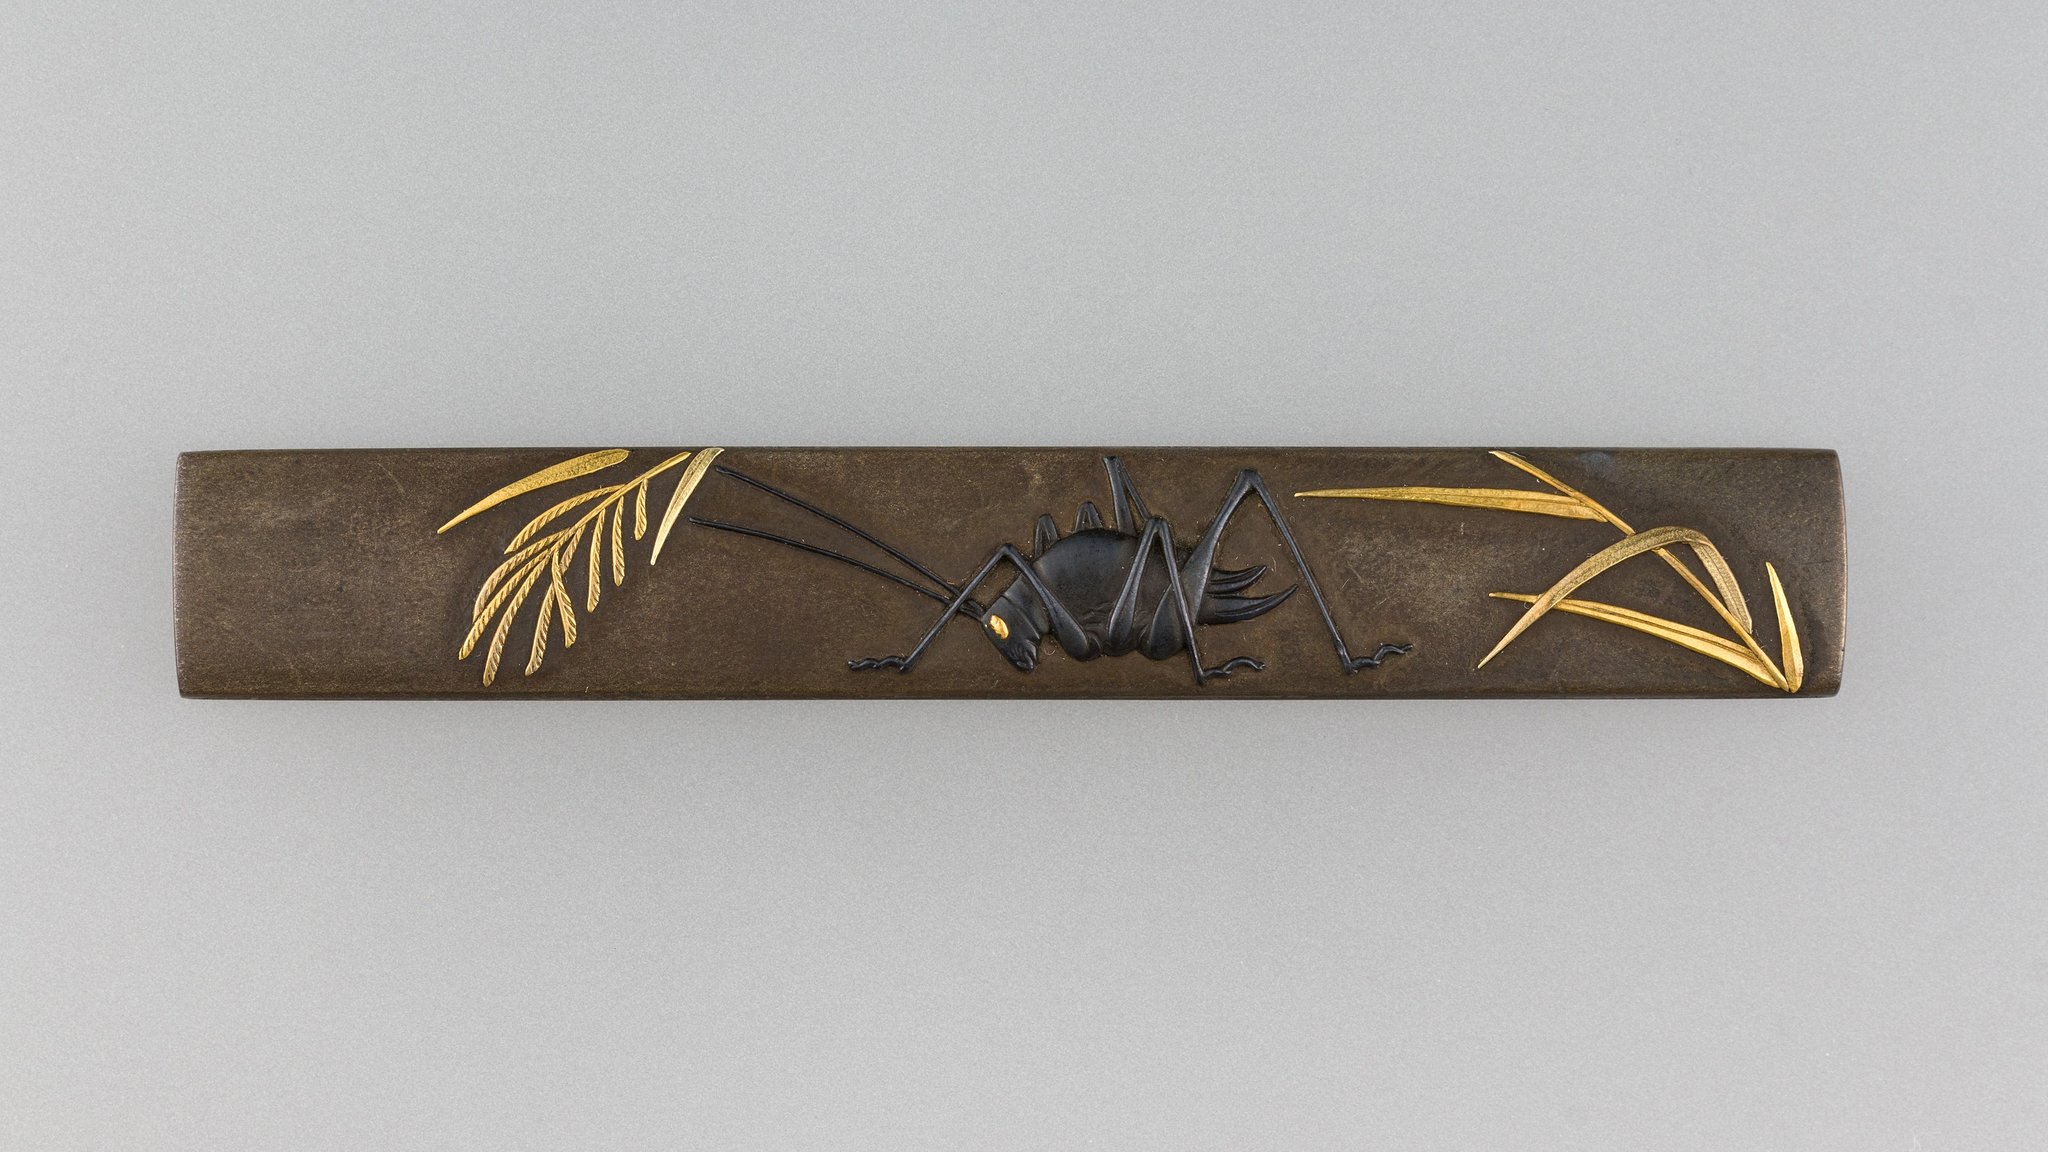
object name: knife handle kozuka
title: Knife Handle (Kozuka)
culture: japanese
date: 1751-1800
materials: gold alloy, silver alloy, gold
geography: japan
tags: insects